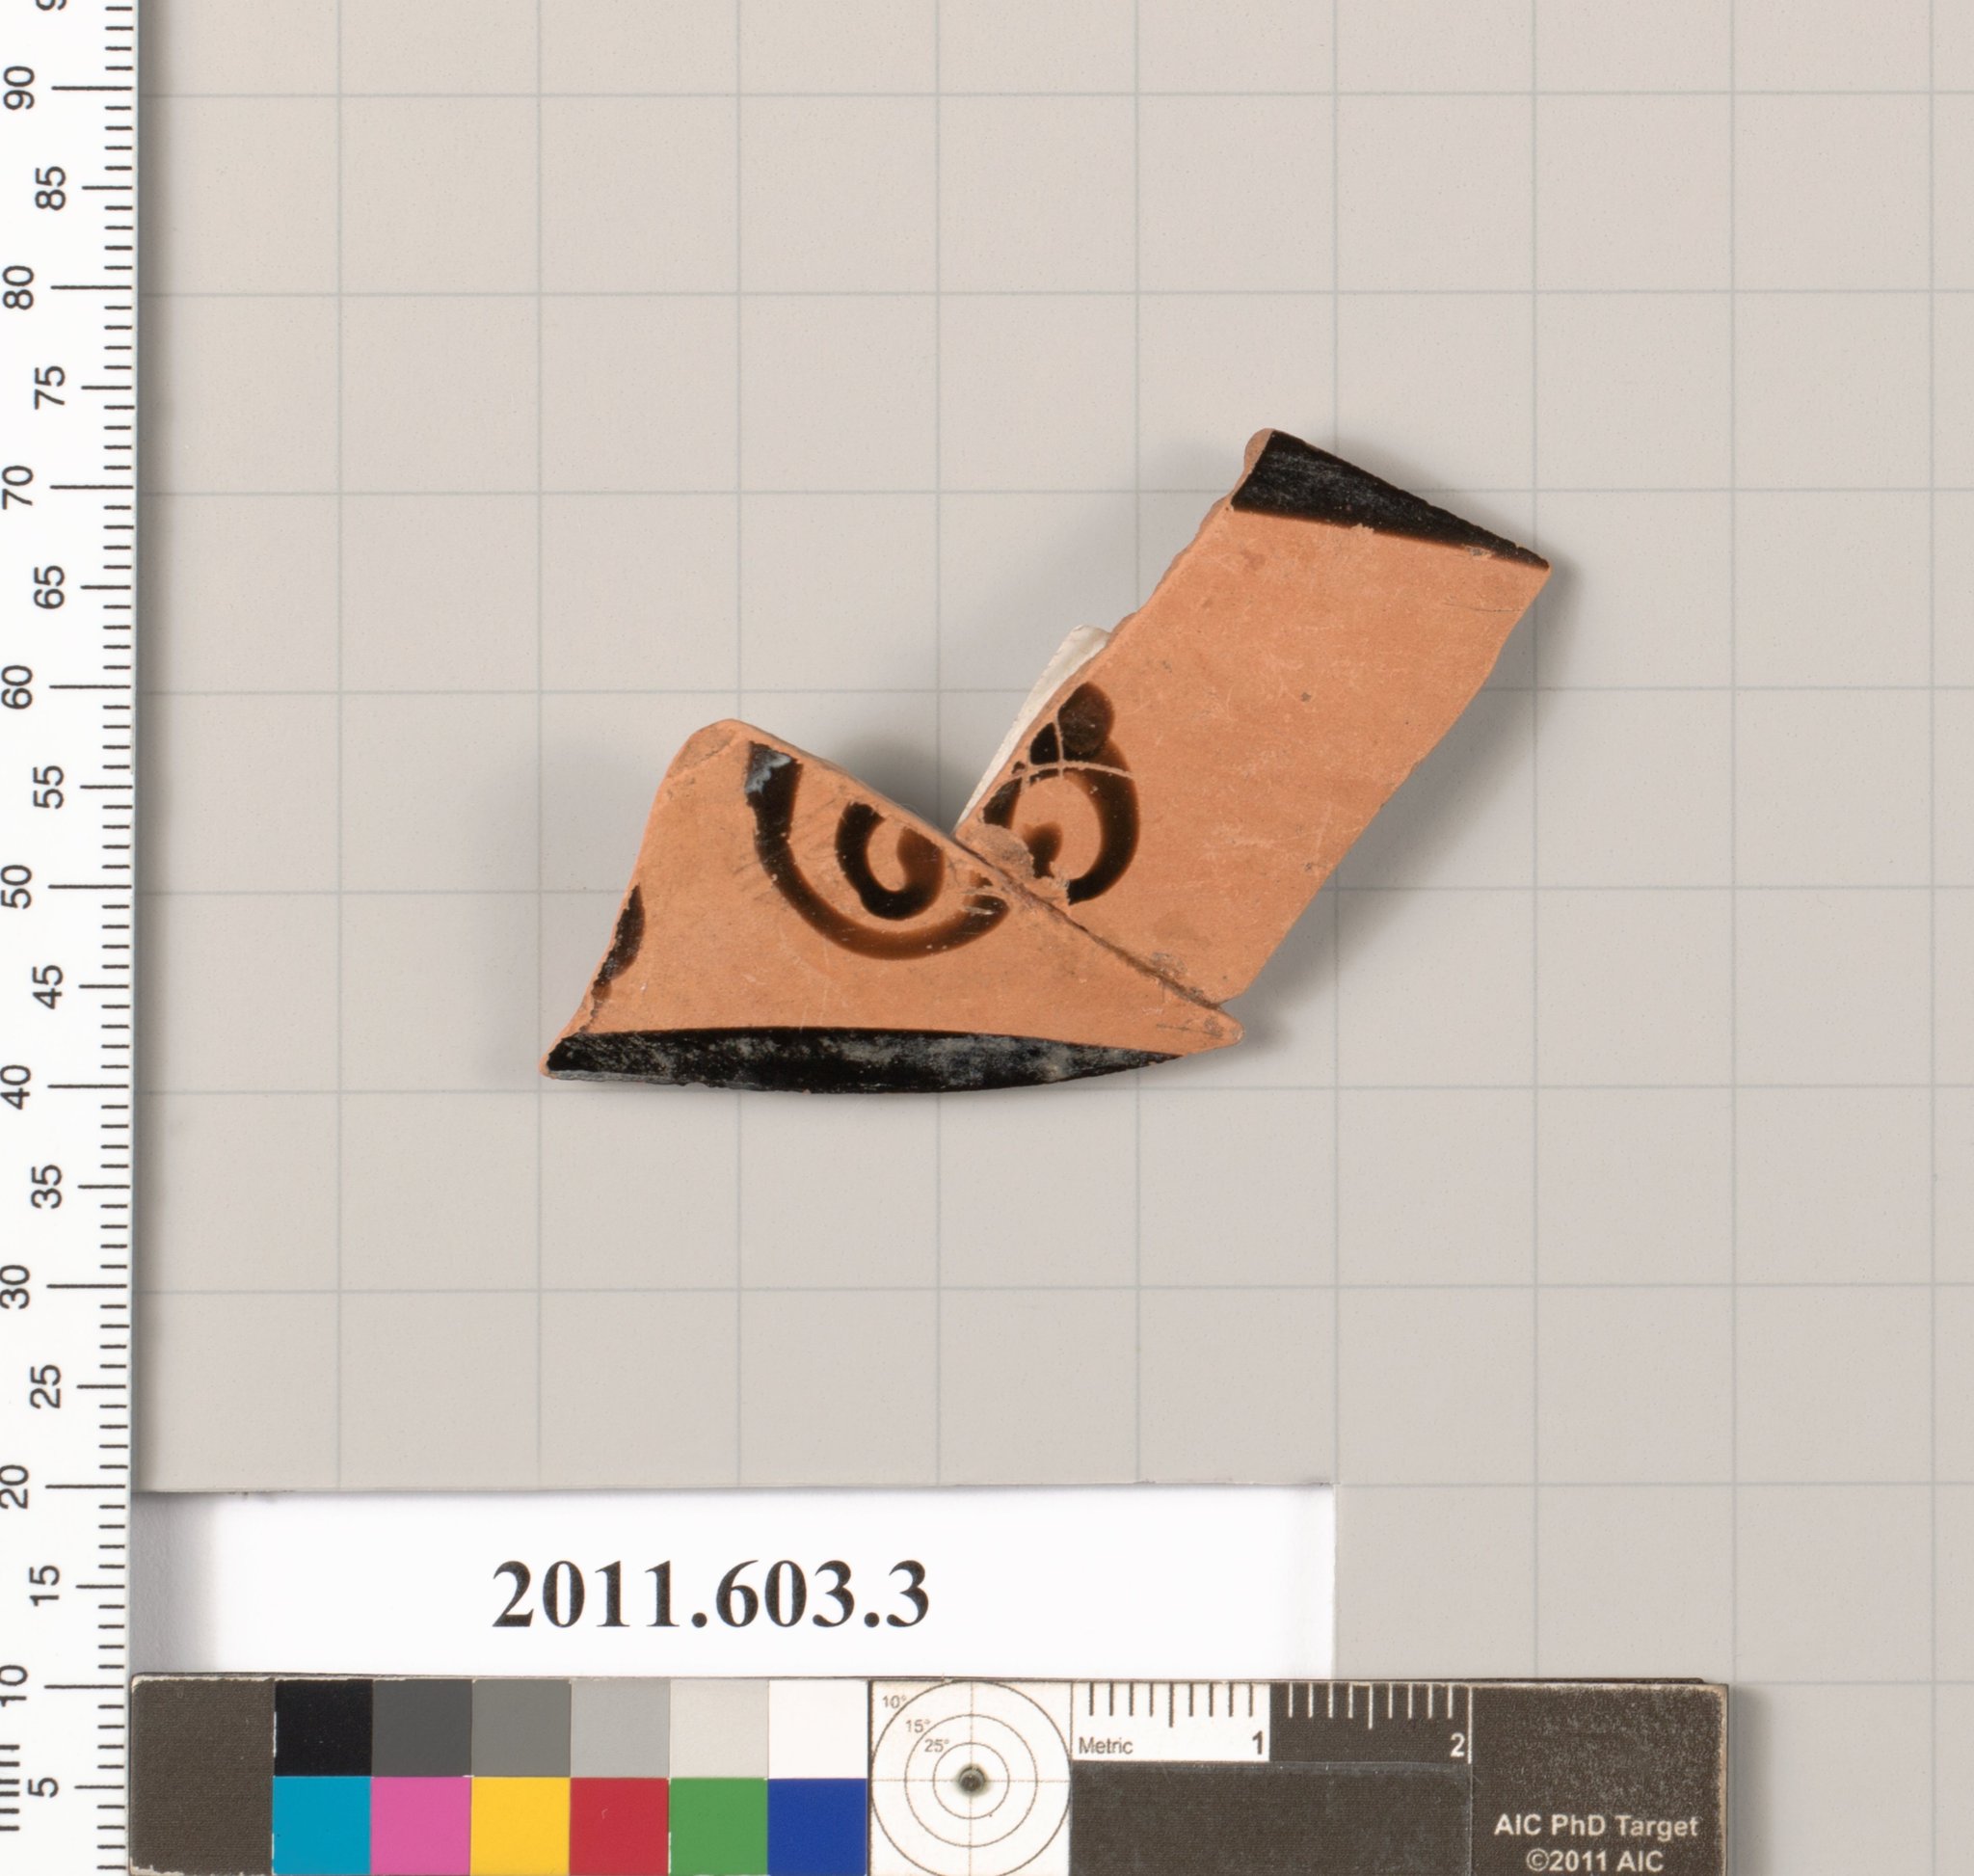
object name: kylix fragment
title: Fragment of a terracotta kylix: band-cup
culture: greek, attic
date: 550-526 BCE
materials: terracotta